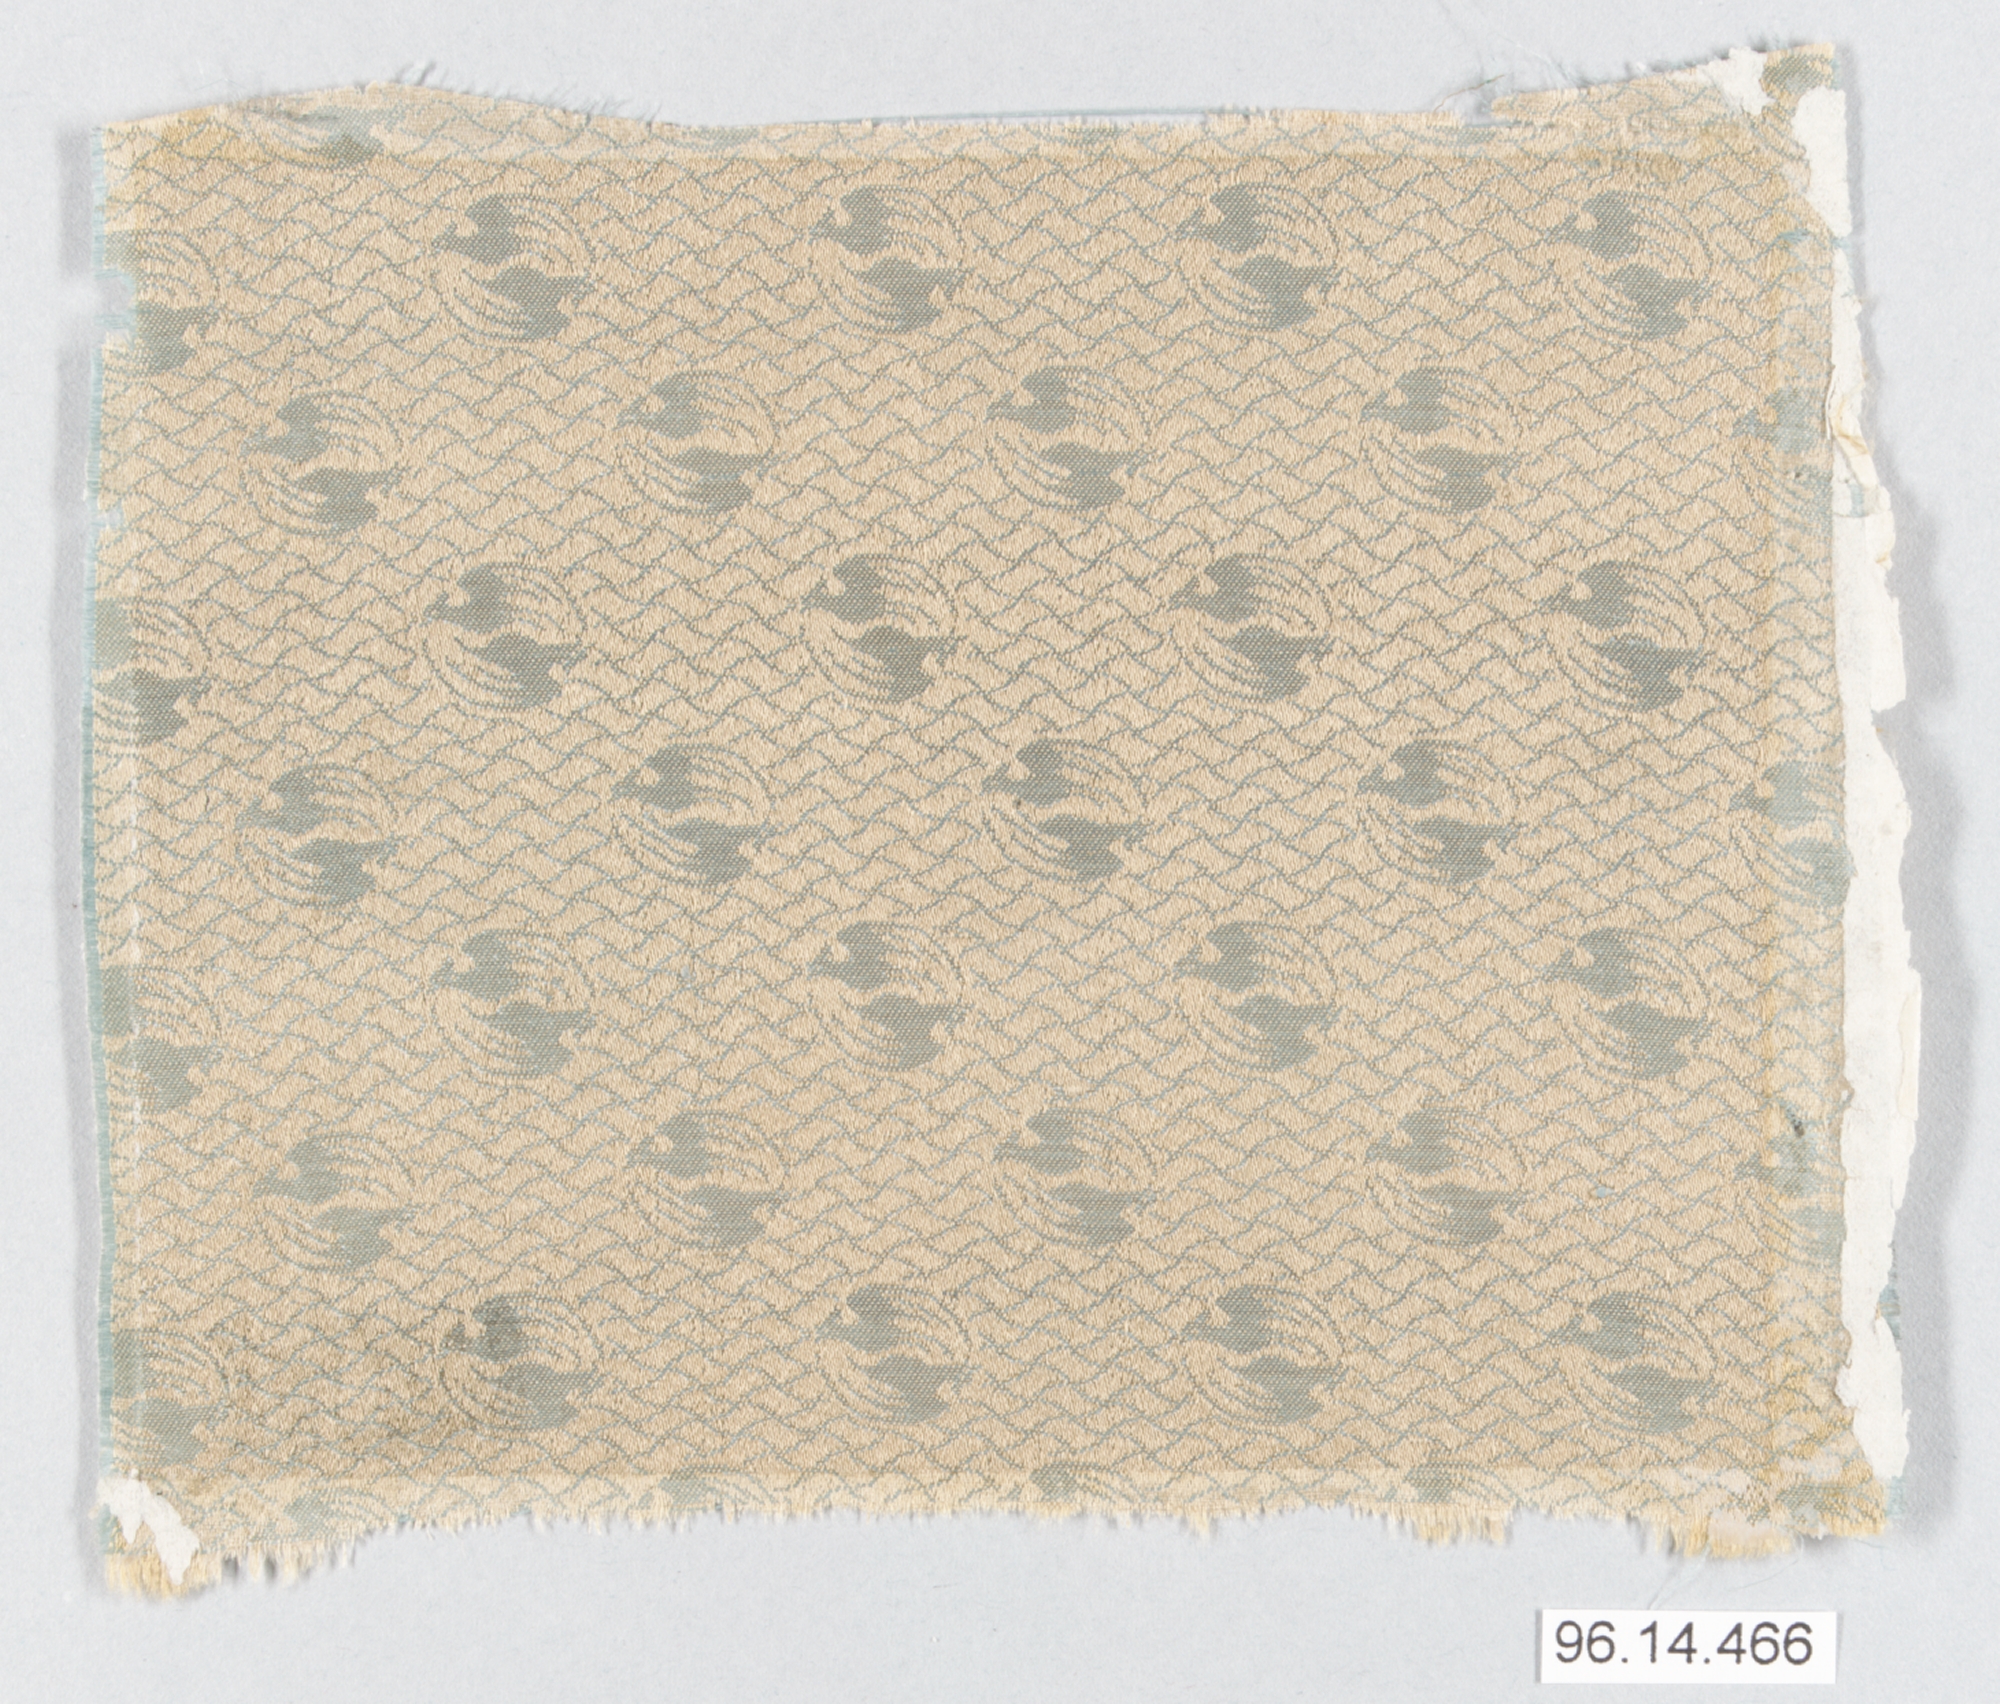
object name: piece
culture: japanese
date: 1801-1900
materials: silk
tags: birds